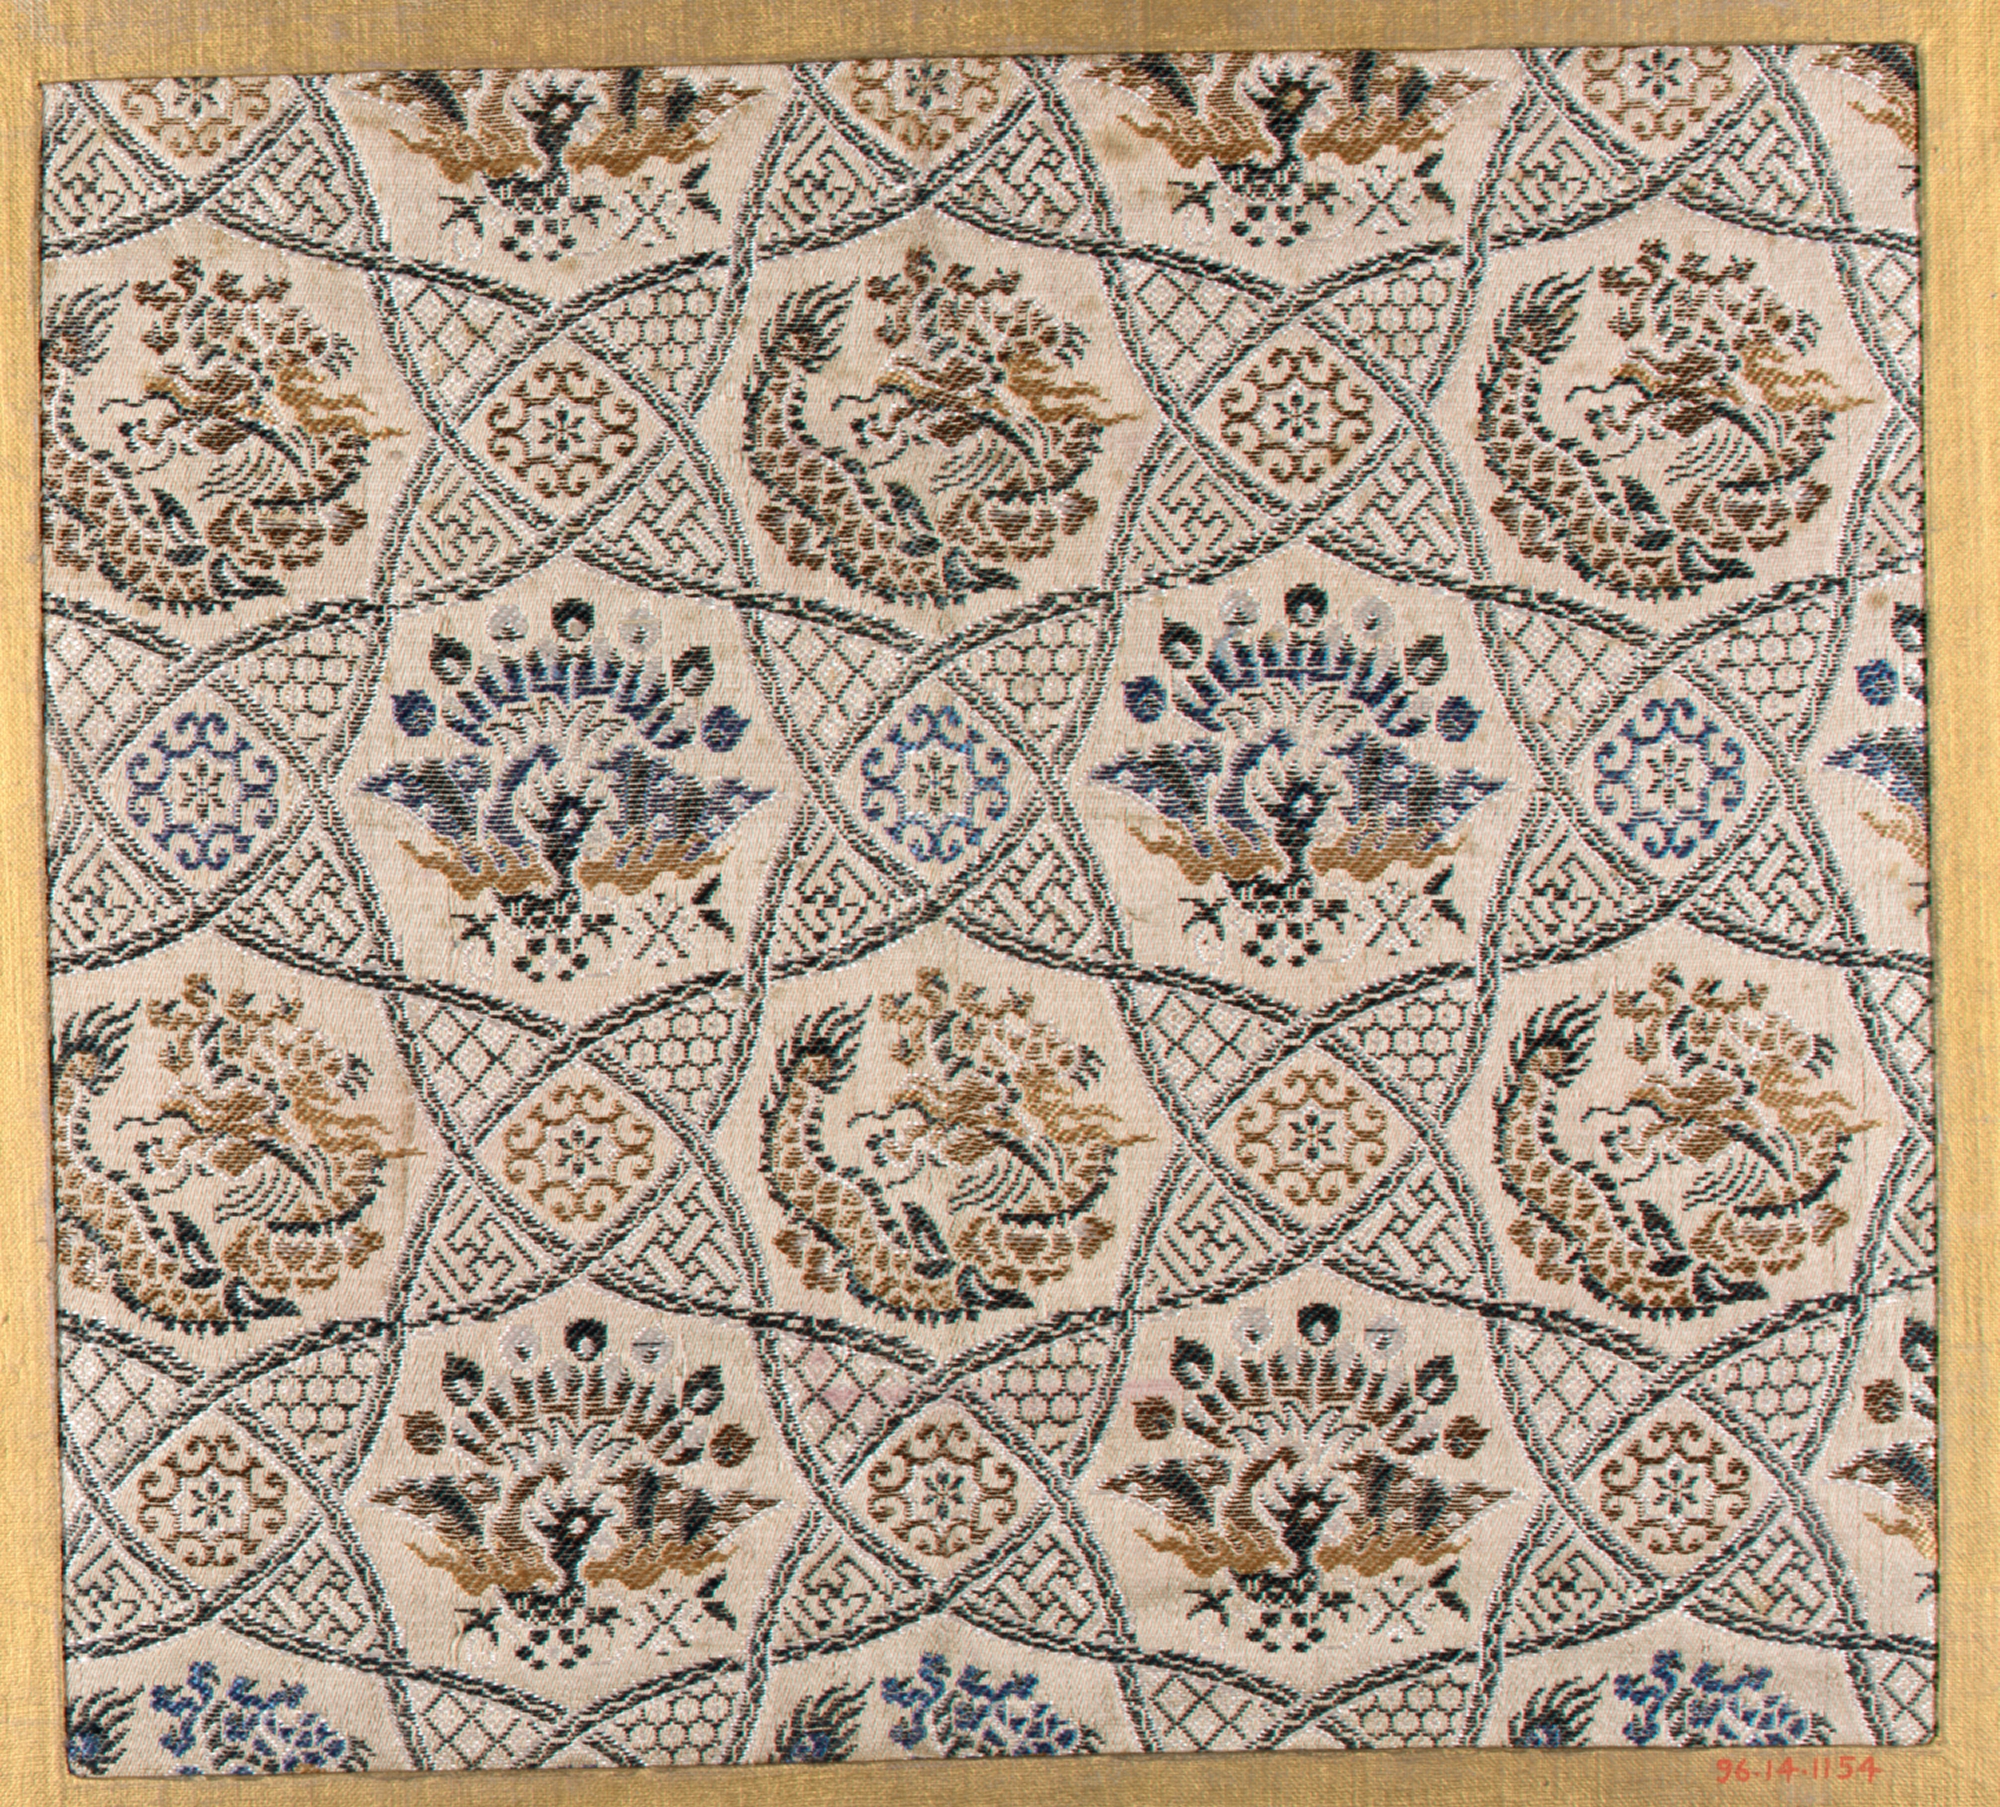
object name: piece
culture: japanese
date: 1701-1900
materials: silk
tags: birds,dragons